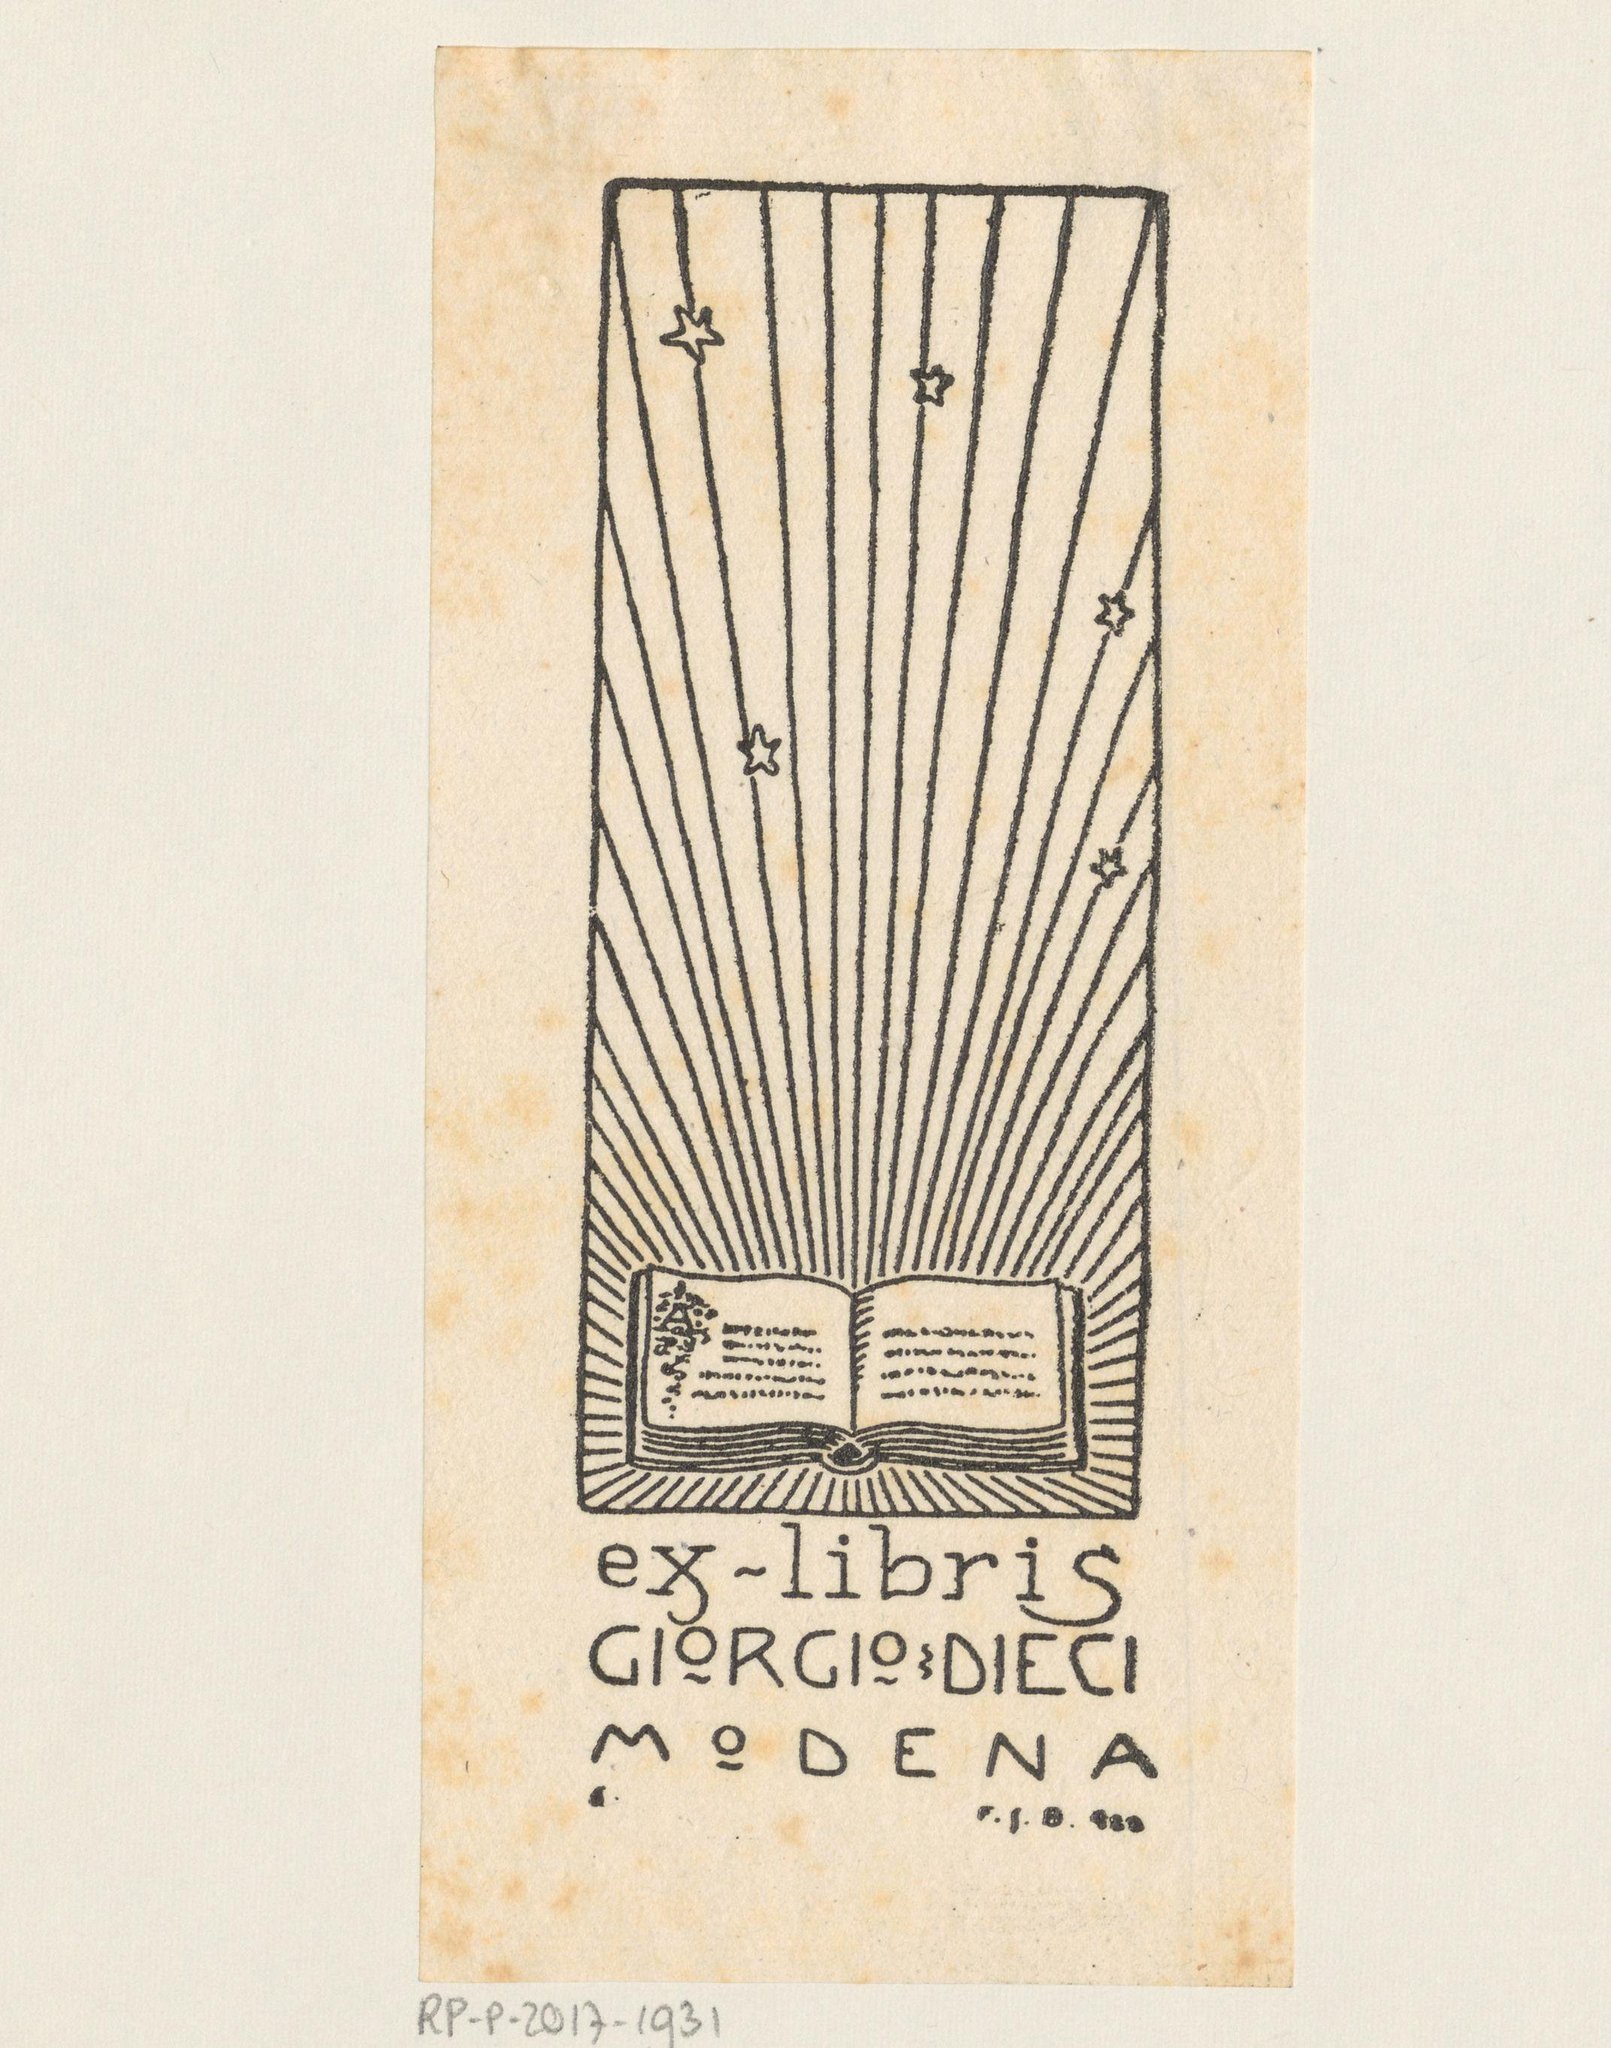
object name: bookplate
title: Ex libris van Giorgio Dieci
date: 1900-1999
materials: paper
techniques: printing block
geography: italy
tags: book, stars